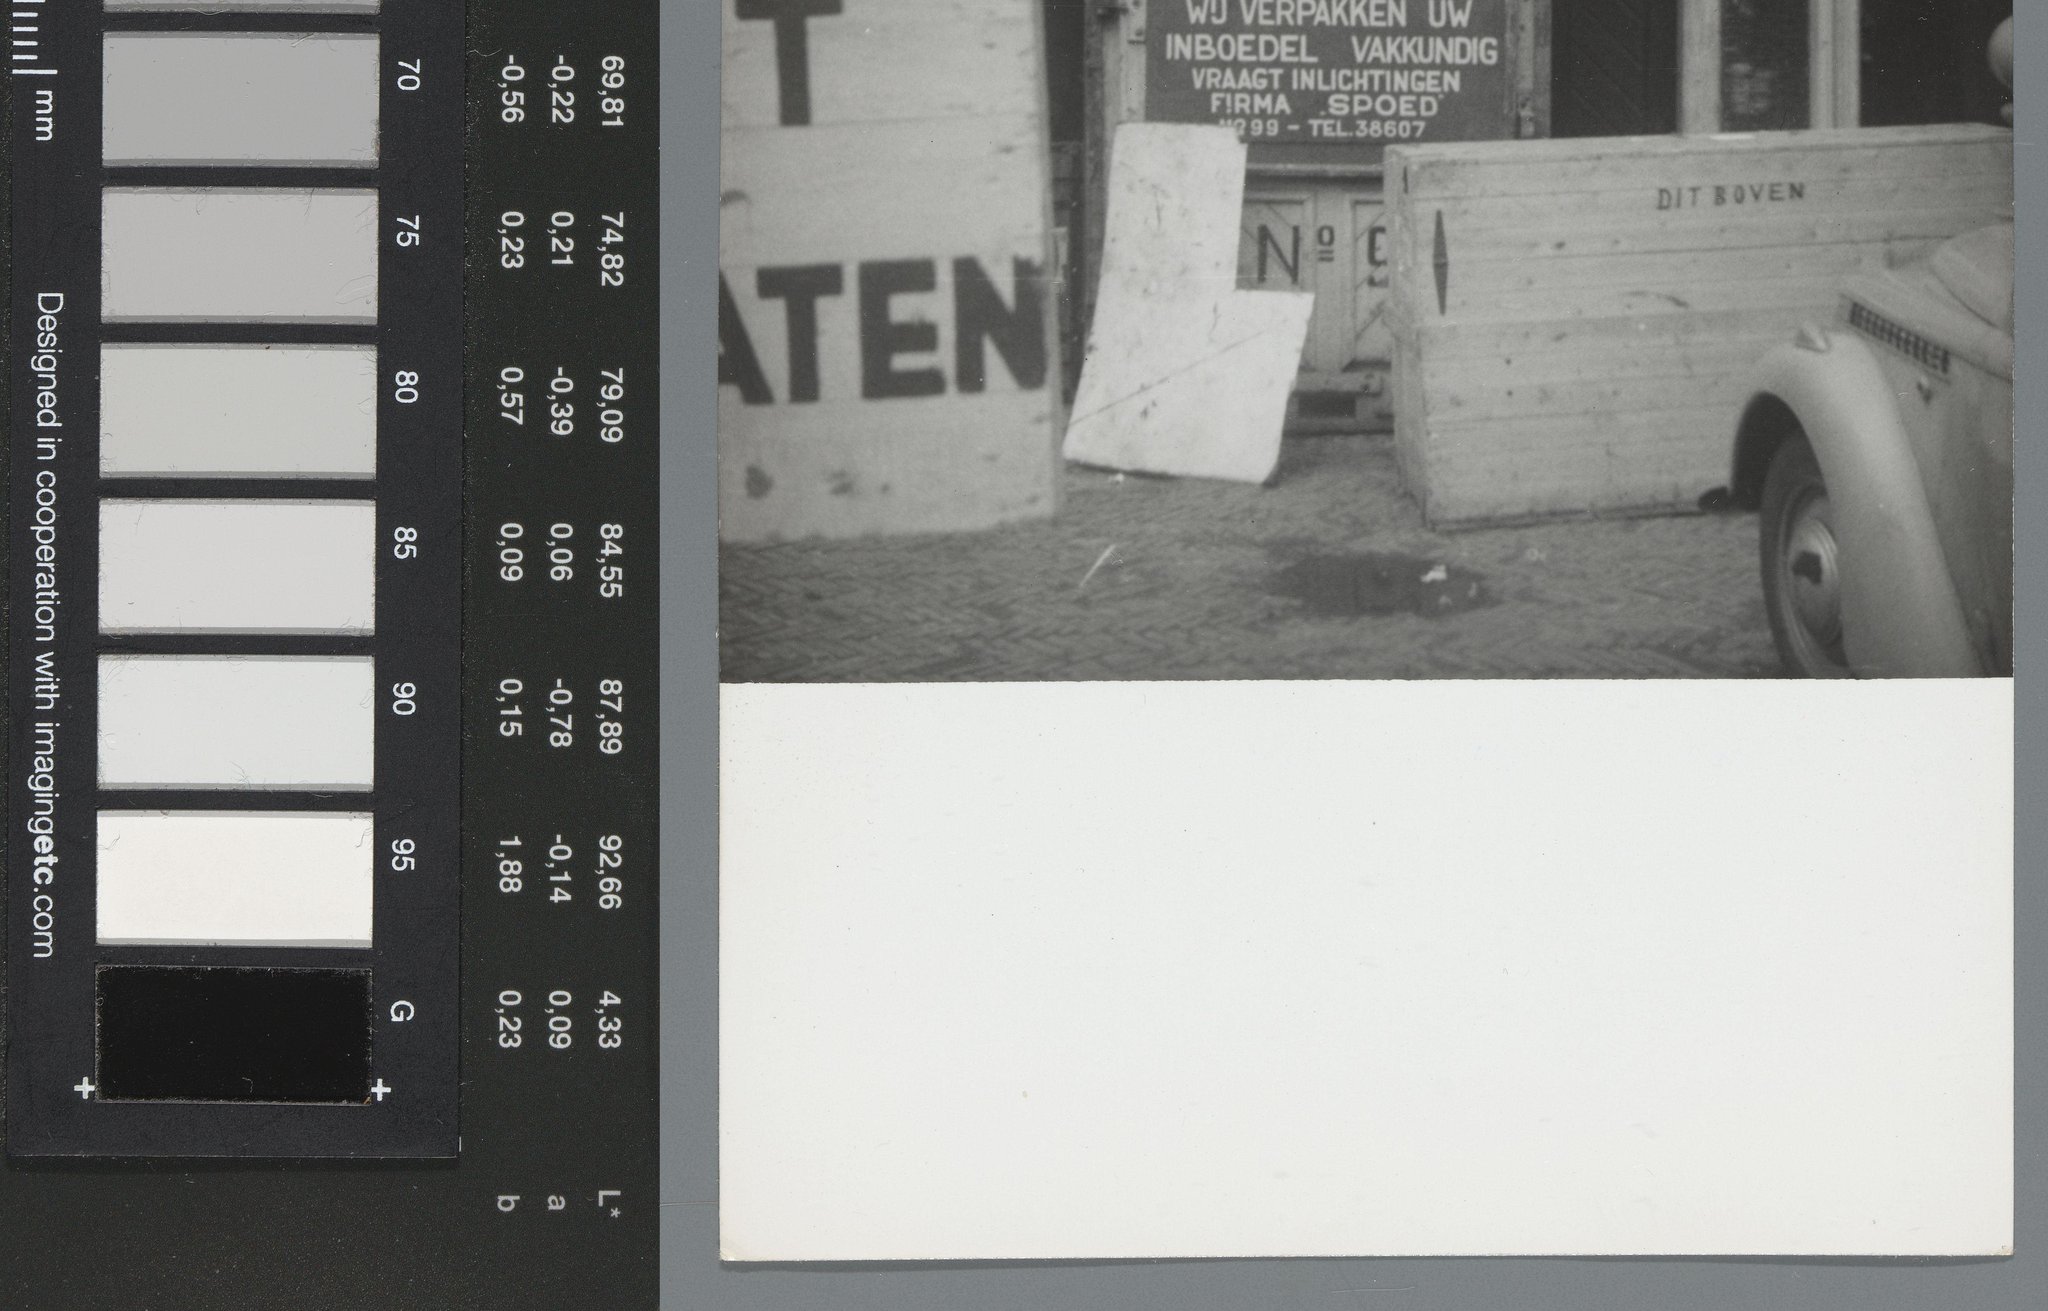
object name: photograph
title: Gaat U emigreren.......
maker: Anonymous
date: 1950-1960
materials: photographic support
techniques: gelatin silver print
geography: netherlands